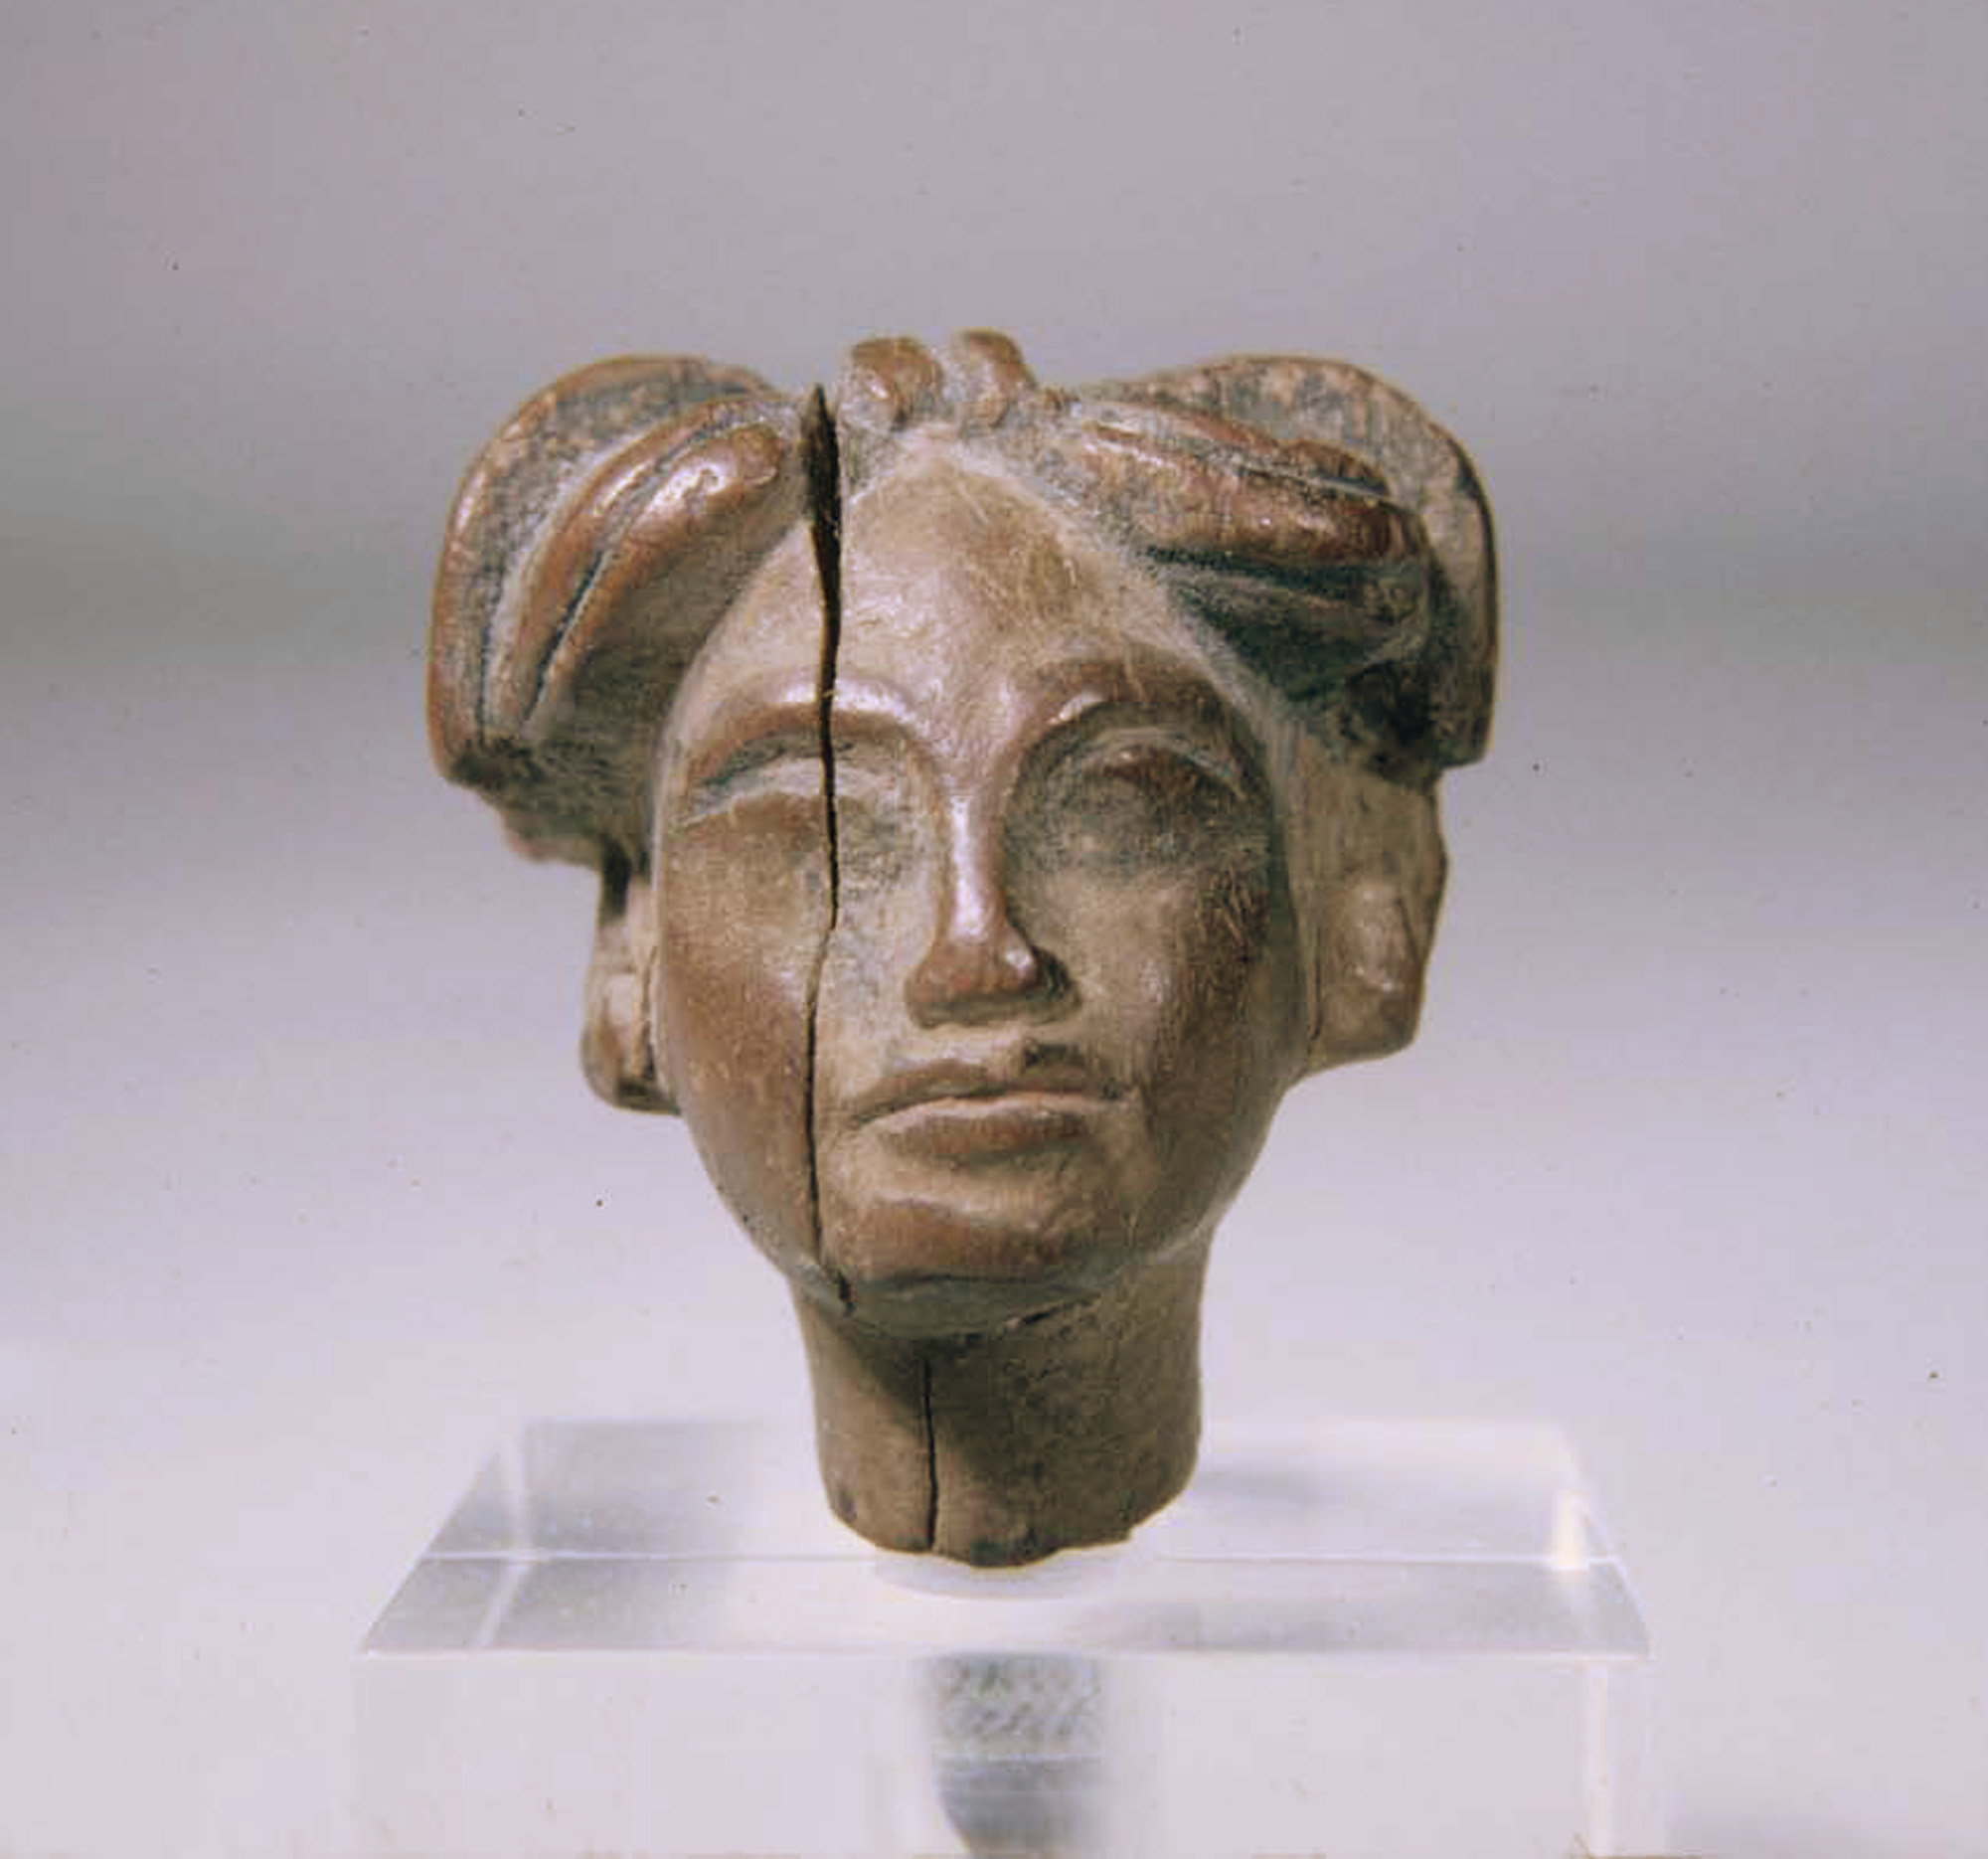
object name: head, woman, from a spoon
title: Head of a woman from a spoon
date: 1353-1295 BCE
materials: wood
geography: egypt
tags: heads,women